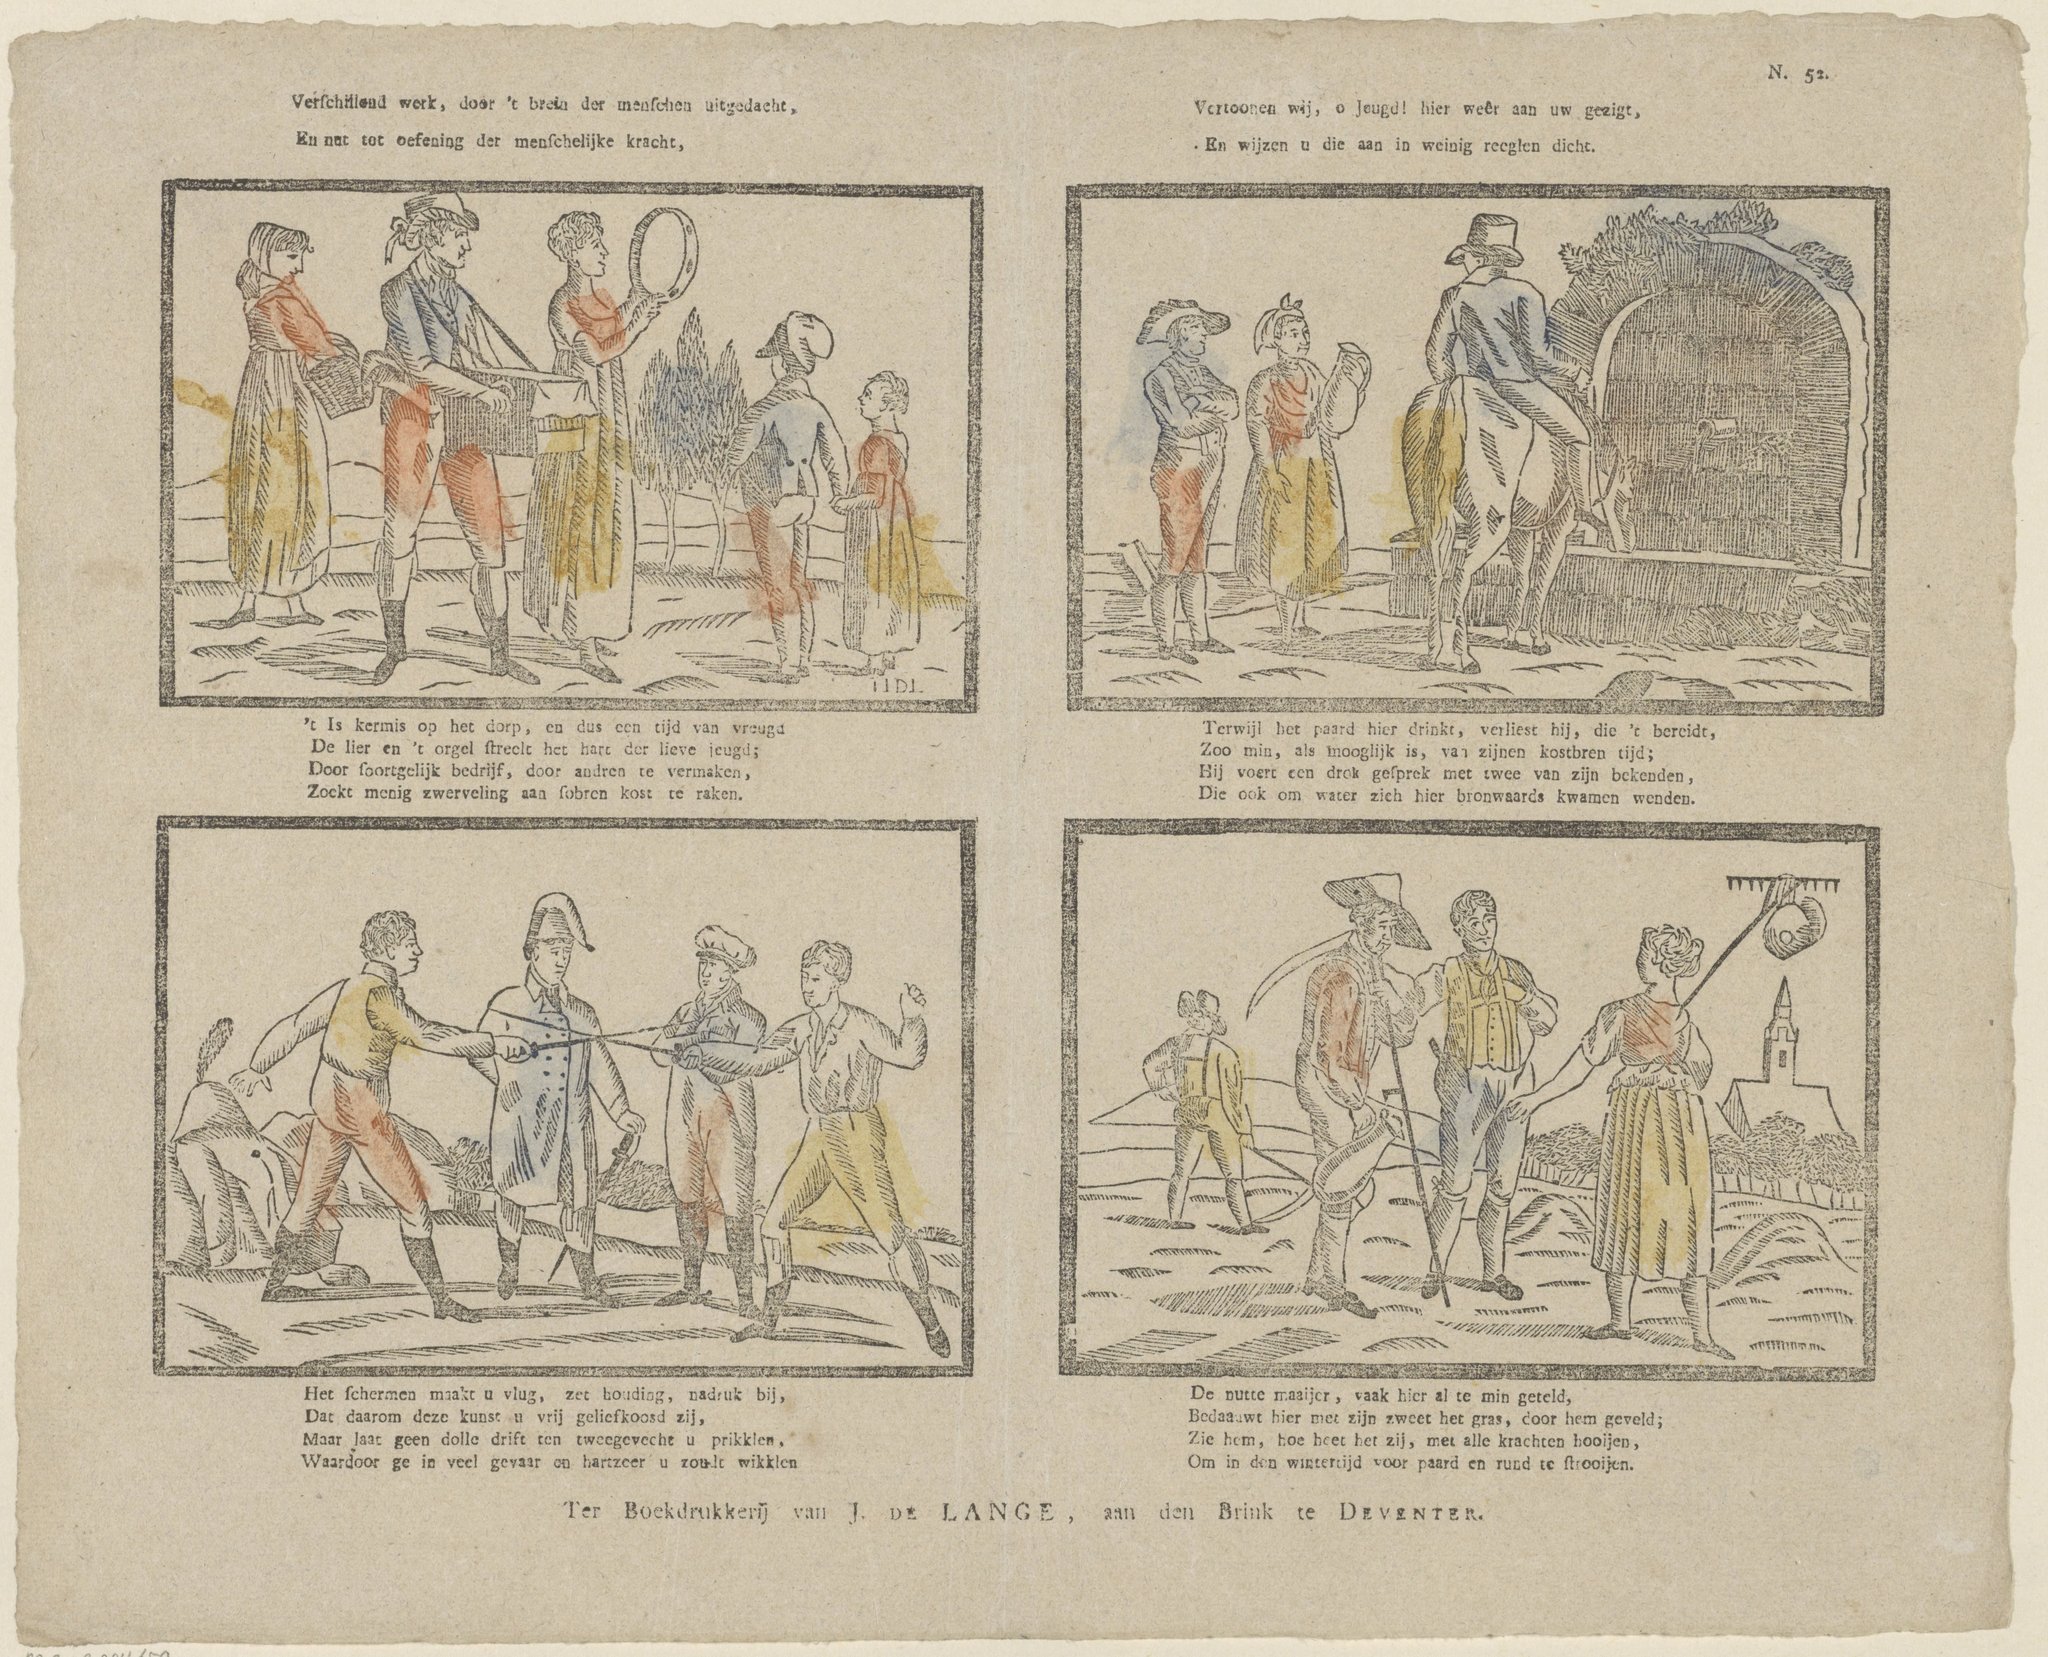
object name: popular print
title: Verschillend werk, door 't brein des menschen uitgedacht, / En nut tot oefening der menschelijke kracht, / Vertoonen wij, o jeugd! hier weêr aan uw gezigt, / En wijzen u die aan in weinig reeglen dicht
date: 1822-1849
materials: paper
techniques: colour, letterpress printing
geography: netherlands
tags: riding a horse, ass, or mule; rider, horseman, farmers, agriculture, fencing (sport)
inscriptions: collector's mark: Lugt 2760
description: Blad met 4 voorstellingen van verschillende bezigheden, waaronder schermen en op het land werken. Onder elke voorstelling een vierregelig vers. Genummerd rechtsboven: N. 52.